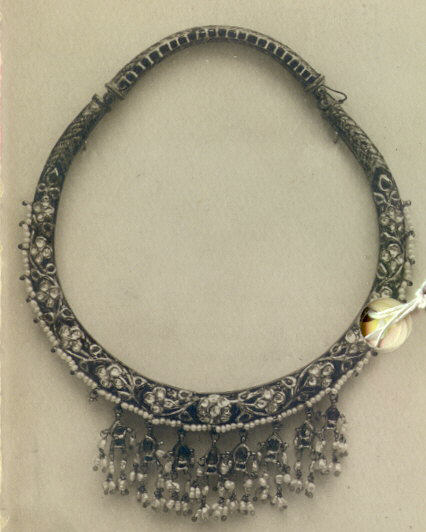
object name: necklace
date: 1701-1800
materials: gold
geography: india